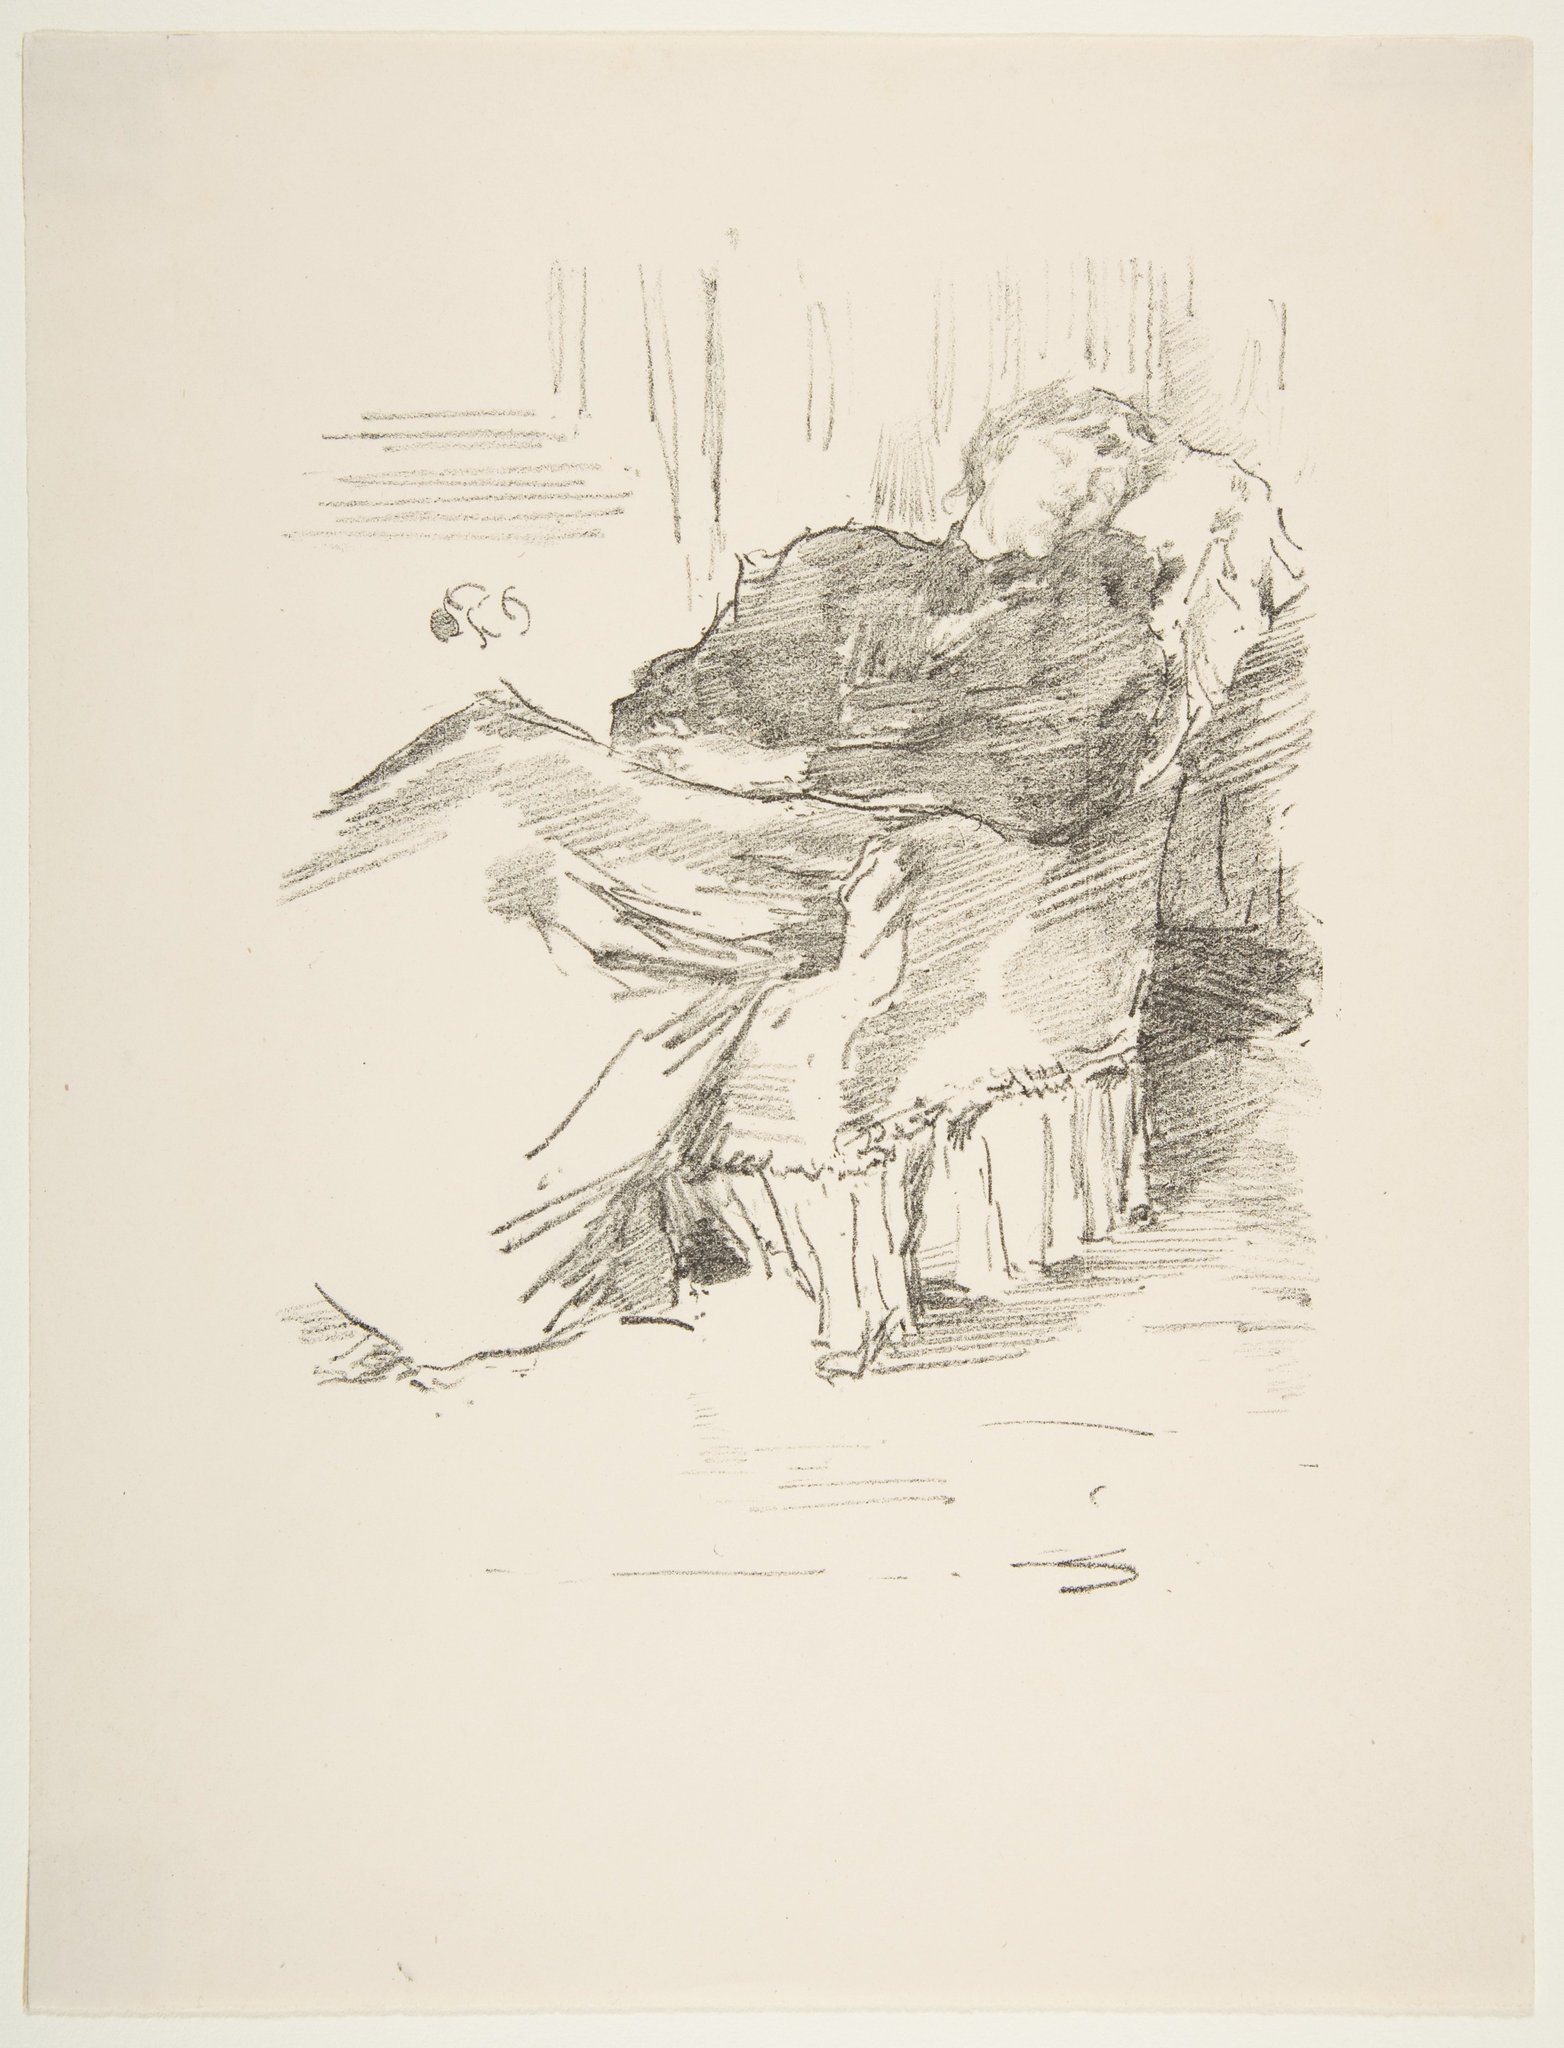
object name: print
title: La Belle Dame Endormie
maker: james mcneill whistler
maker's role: artist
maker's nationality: american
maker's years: 1834-1903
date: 1894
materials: ink, paper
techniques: printing, lithography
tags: sleeping,women